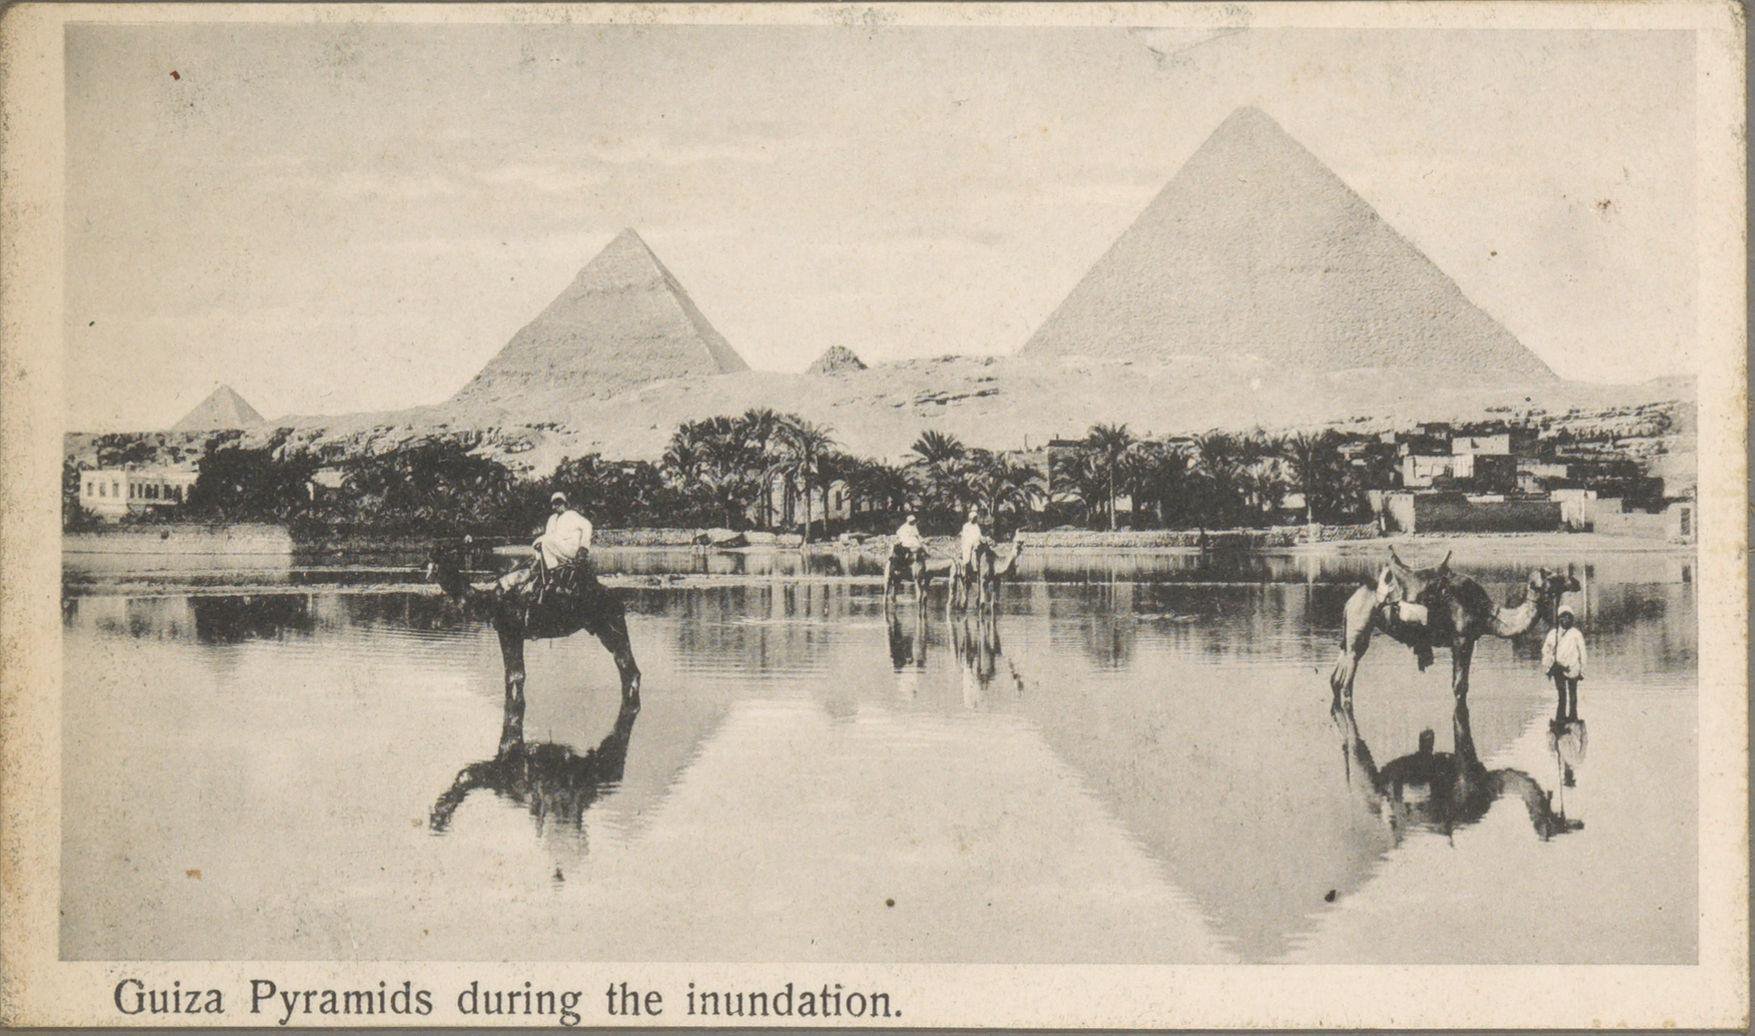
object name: photograph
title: Piramides van Gizeh tijdens overstroming, op de voorgrond mannen op kamelen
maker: Anonymous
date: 1895-1905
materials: paper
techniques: photograph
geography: gizeh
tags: flood, high tide, hoofed animals, pyramid (historical grave form)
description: Onderdeel van Reisalbum met foto's van bezienswaardigheden in Griekenland en Egypte.